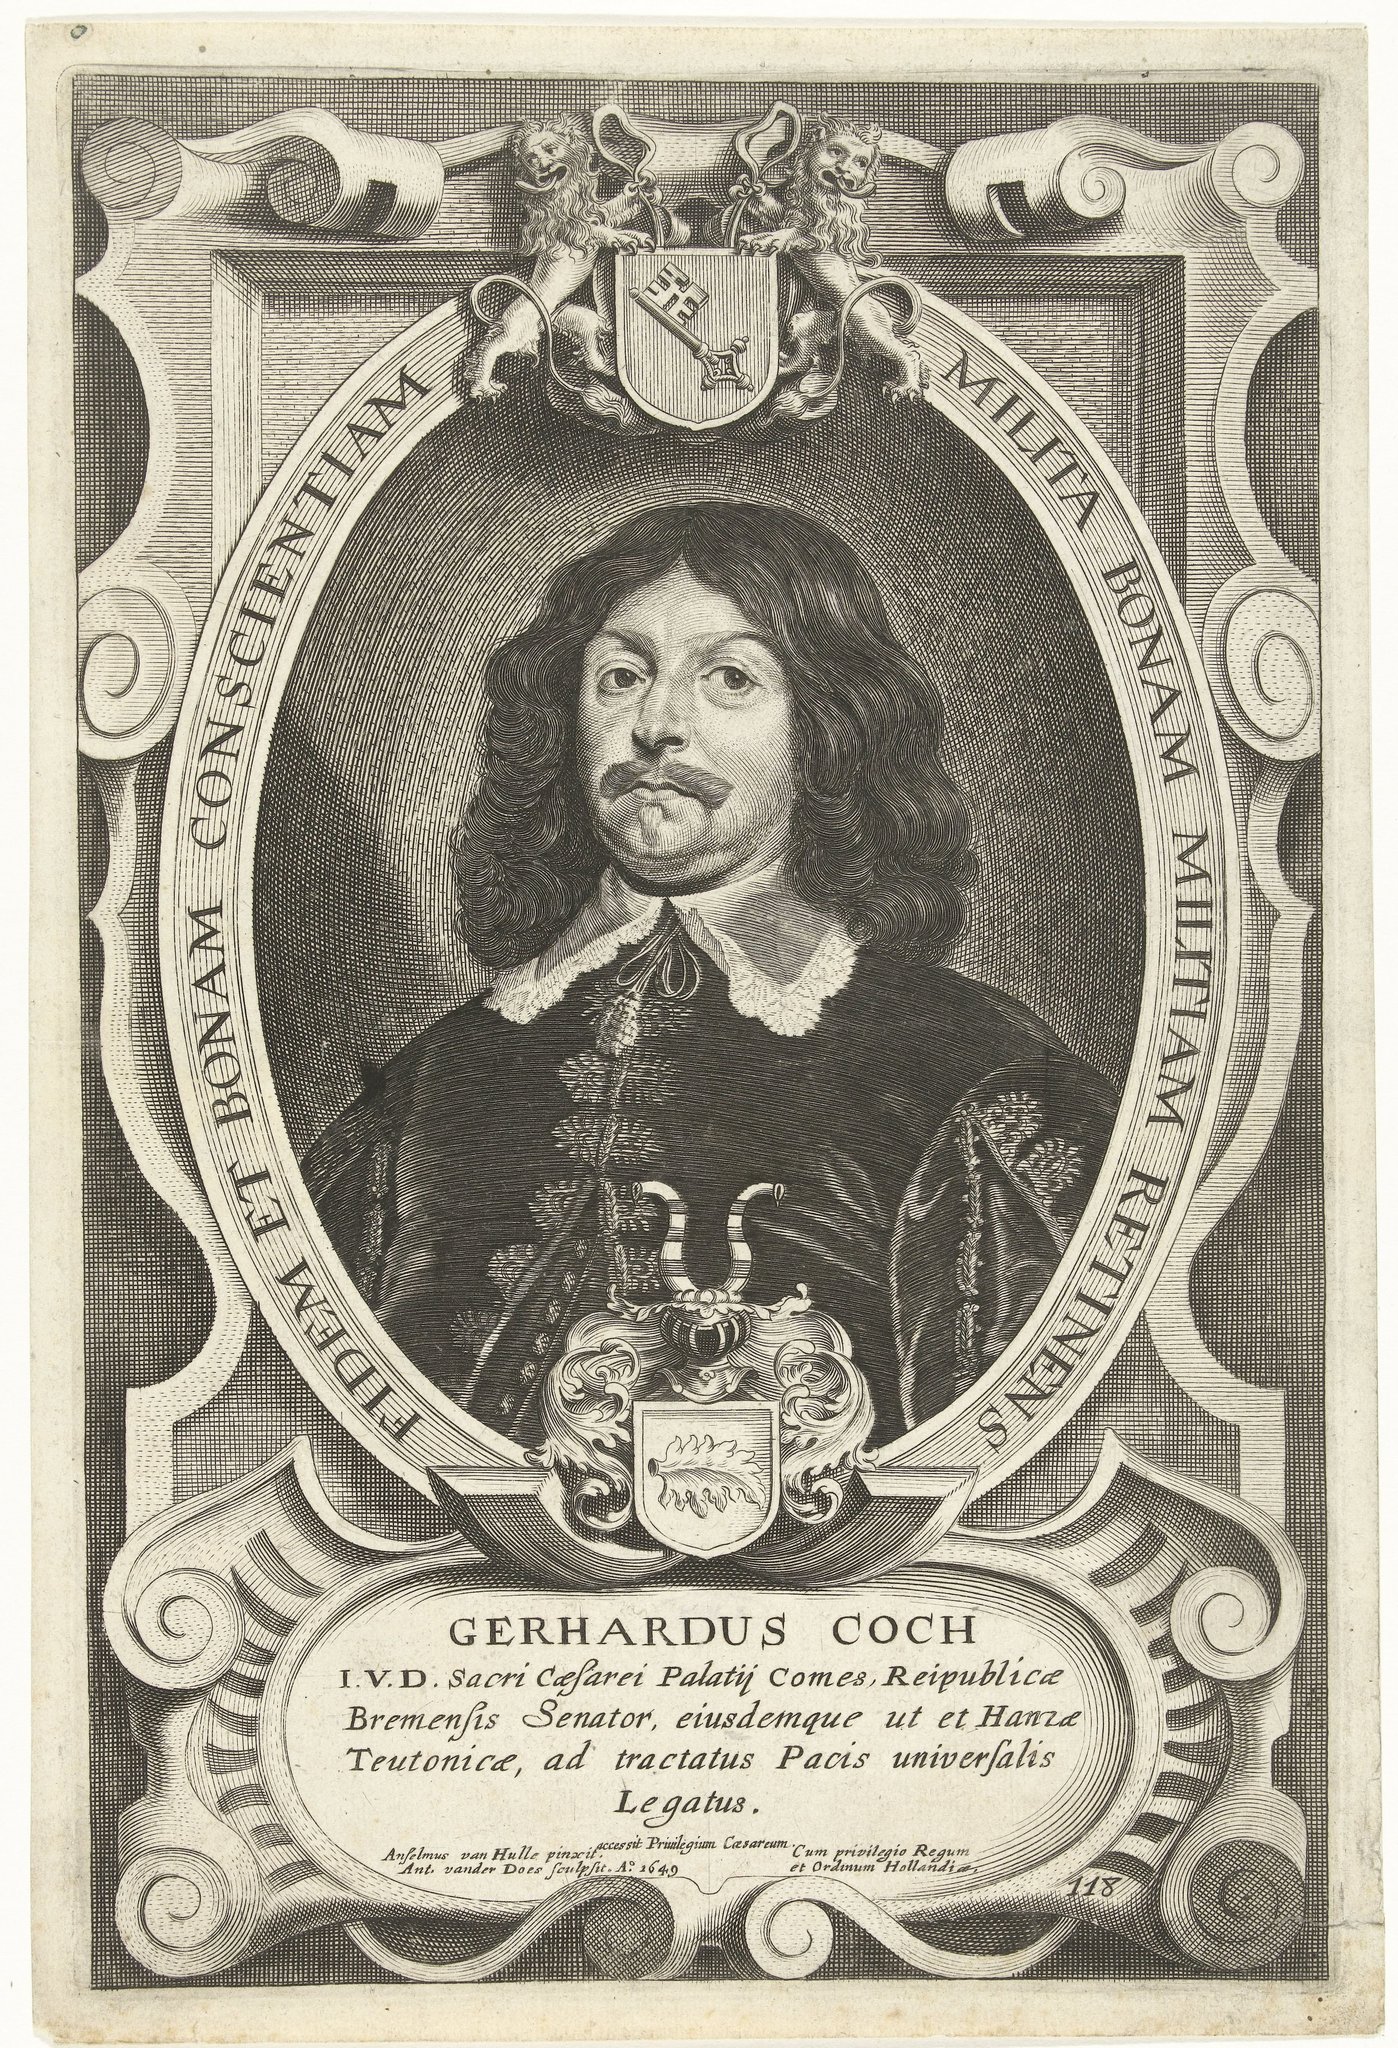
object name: print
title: Portret van Gerhard Koch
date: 1649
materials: paper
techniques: engraving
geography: southern netherlands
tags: gerhard koch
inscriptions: collector's mark: Lugt 2228, number: ‘118’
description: Portret van Gerhard Koch, borststuk in ovaal met wapenschilden, in cartouche met onder het portret vijf regels Latijnse tekst.